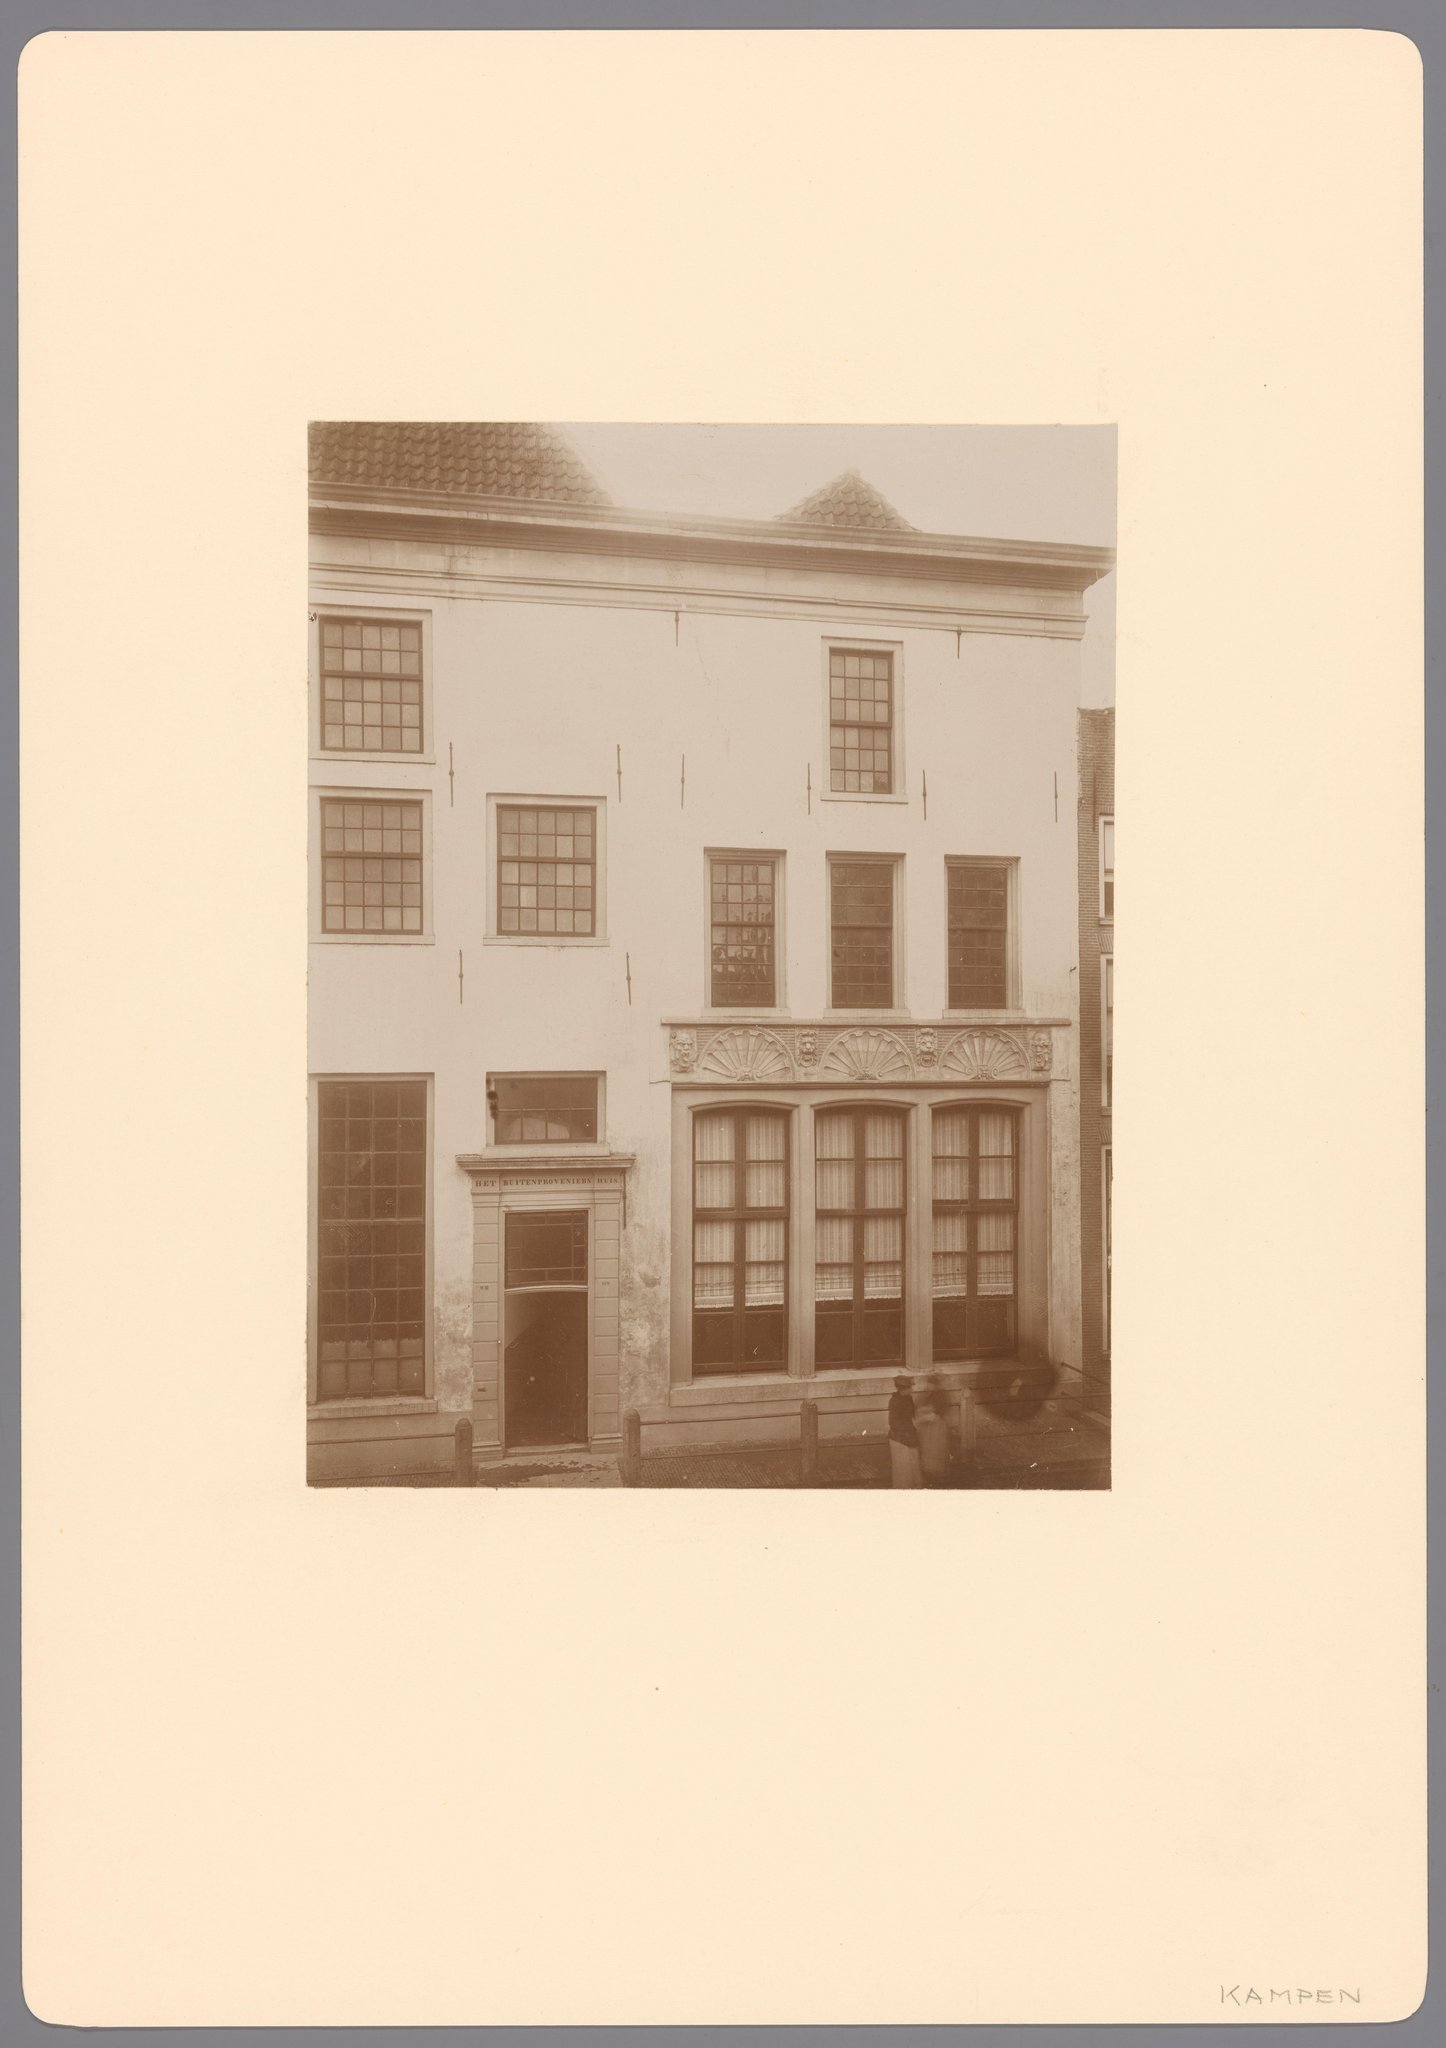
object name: photograph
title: Façade van het Buiten-Proveniershuis te Kampen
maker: anoniem (monumentenzorg)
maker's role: fotograaf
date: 1896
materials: cardboard, photographic support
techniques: collodion silver print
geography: kampen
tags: urban housing, façade (of house or building)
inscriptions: annotation: ‘Kampen’, annotation: ‘Kampen/ Het buitenproveniershuis aan de Nieuwstraat/ nov 1896’